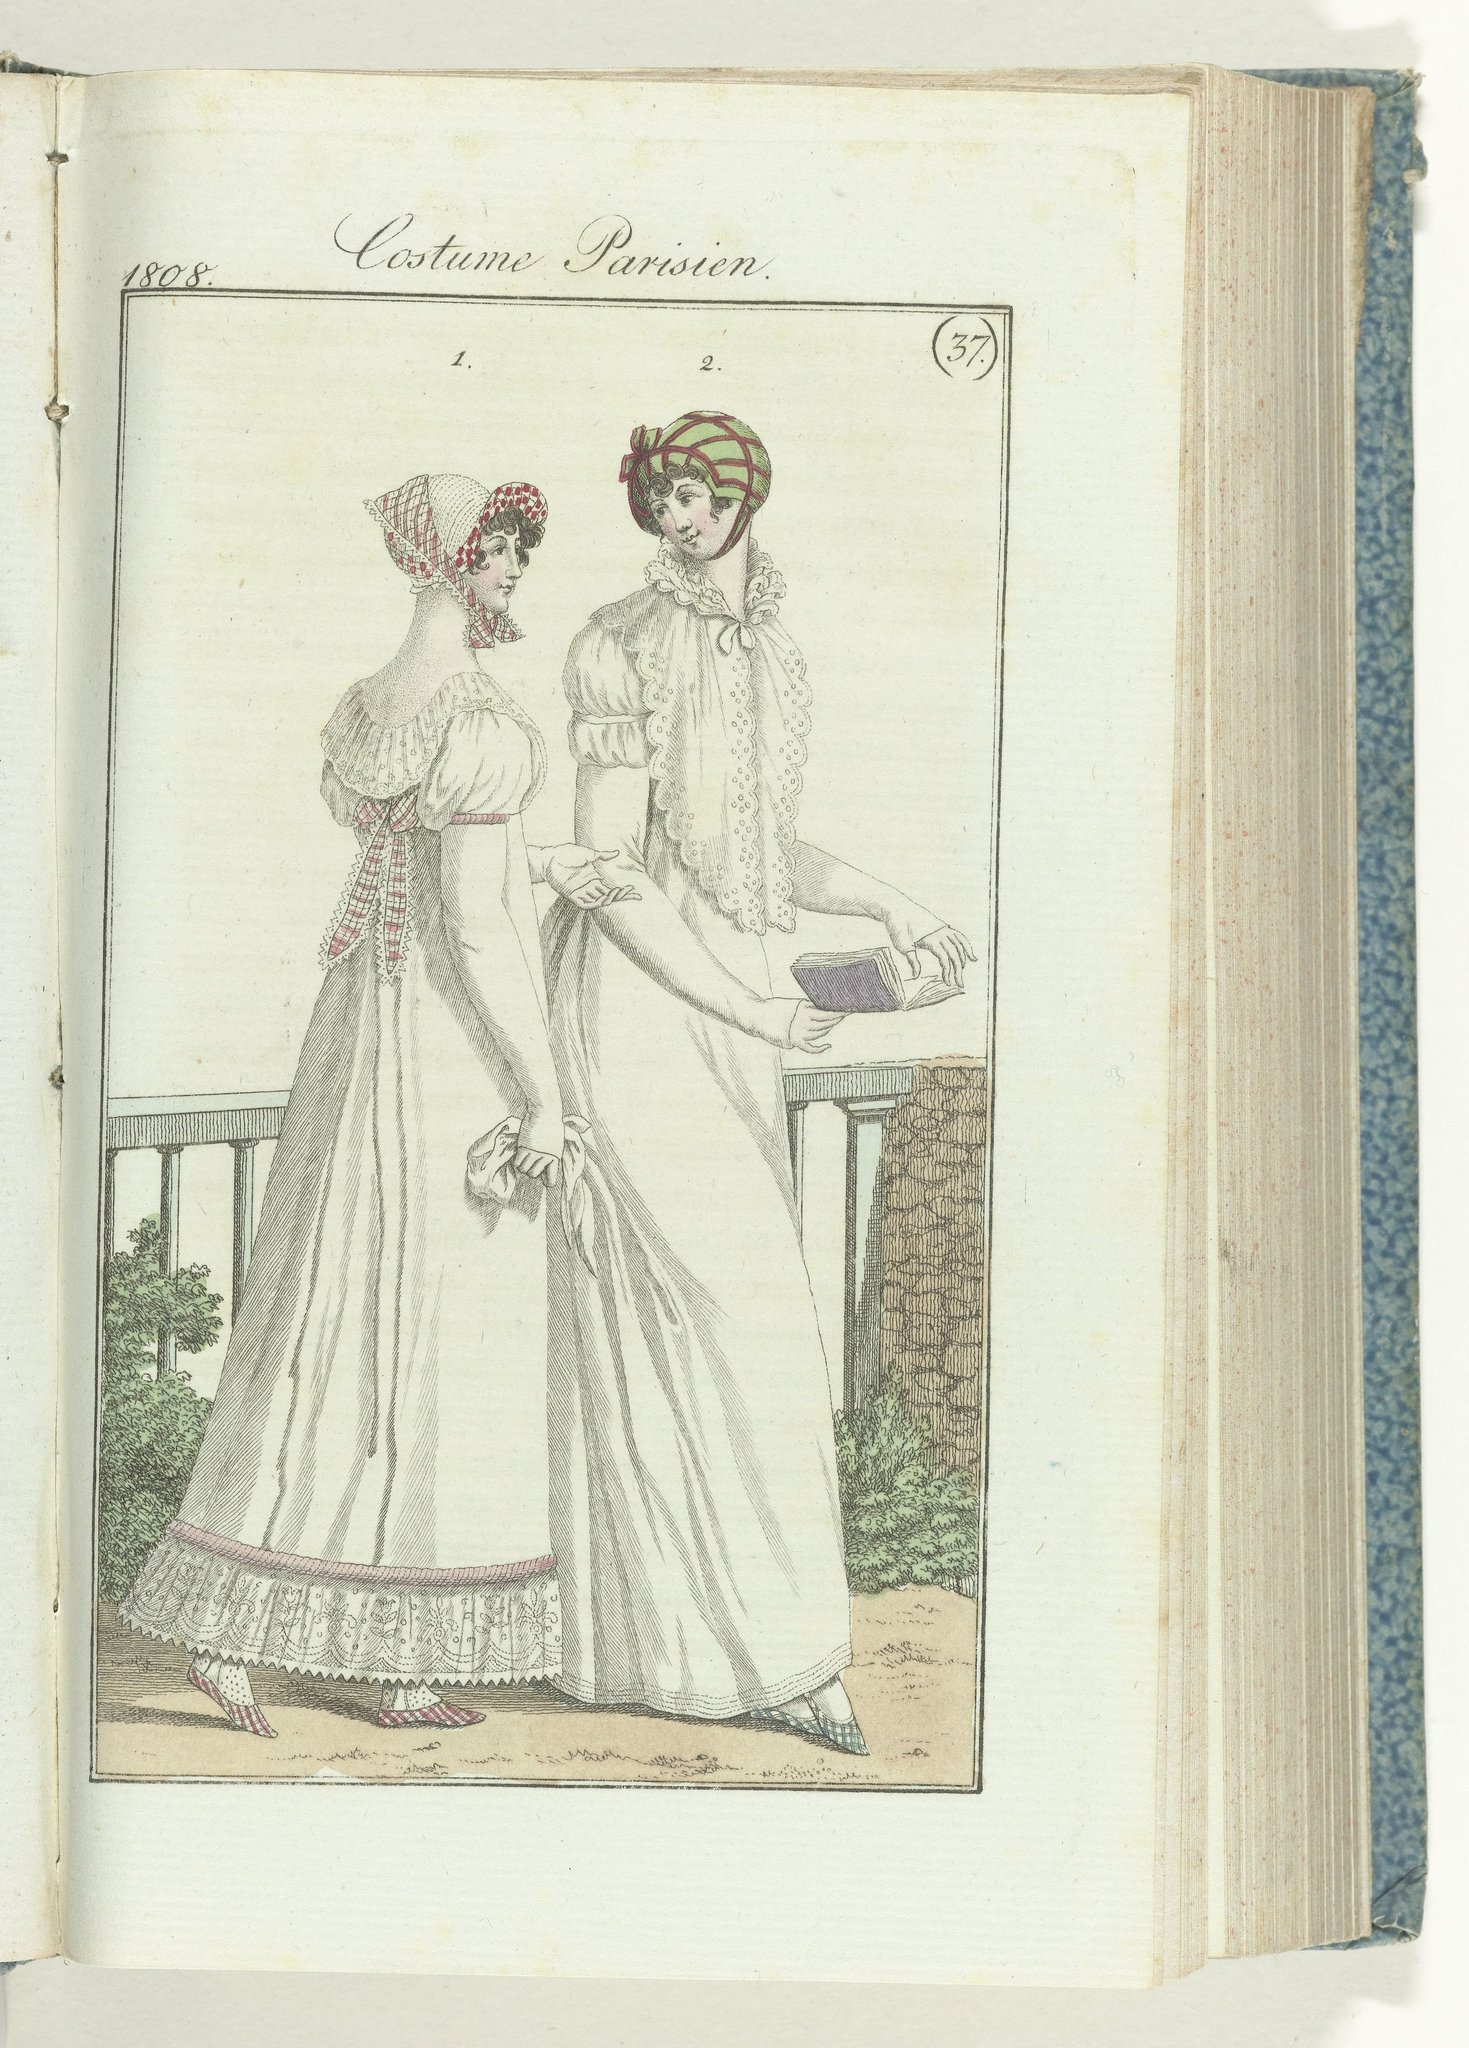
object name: fashion print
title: Journal des Dames et des Modes, editie Frankfurt 11 septembre 1808, Costume Parisien (37)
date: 1808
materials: paper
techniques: engraving, hand coloring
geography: frankfurt am main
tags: clothing for the upper part of the body (pelerine) (+ women's clothes), gloves, mittens (mitaines) (+ women's clothes), head-gear (headscarf) (+ women's clothes), fashion plates, head-gear: hat (+ women's clothes), shoes, sandals (+ women's clothes), dress, gown (+ women's clothes), belt, girdle, waistband (+ women's clothes)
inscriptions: title: ‘Costume Parisien.’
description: De begeleidende tekst (p. 287 en 288) vermeldt: Fig. 1: 'Marmotte' (naam voor bepaald soort hoofddoekje) van tafzijde met een rand van kant. Japon van perkale, met geborduurde onderrand. Ceintuur van tafzijde, afgezet met tule. Roze geblokte schoenen. Fig. 2: Hoed van groene tafzijde, met rode biezen. Japon van perkale. Korte mouwen. Pelerine 'à pointes de fichu'. Witte mitaines, wit-groen geblokte schoenen. De prent maakt deel uit van het modetijdschrift Journal des Dames et des Modes, uitgegeven in Frankfurt als kopie van de Franse editie van Pierre de la Mésangère, (1798-1848).